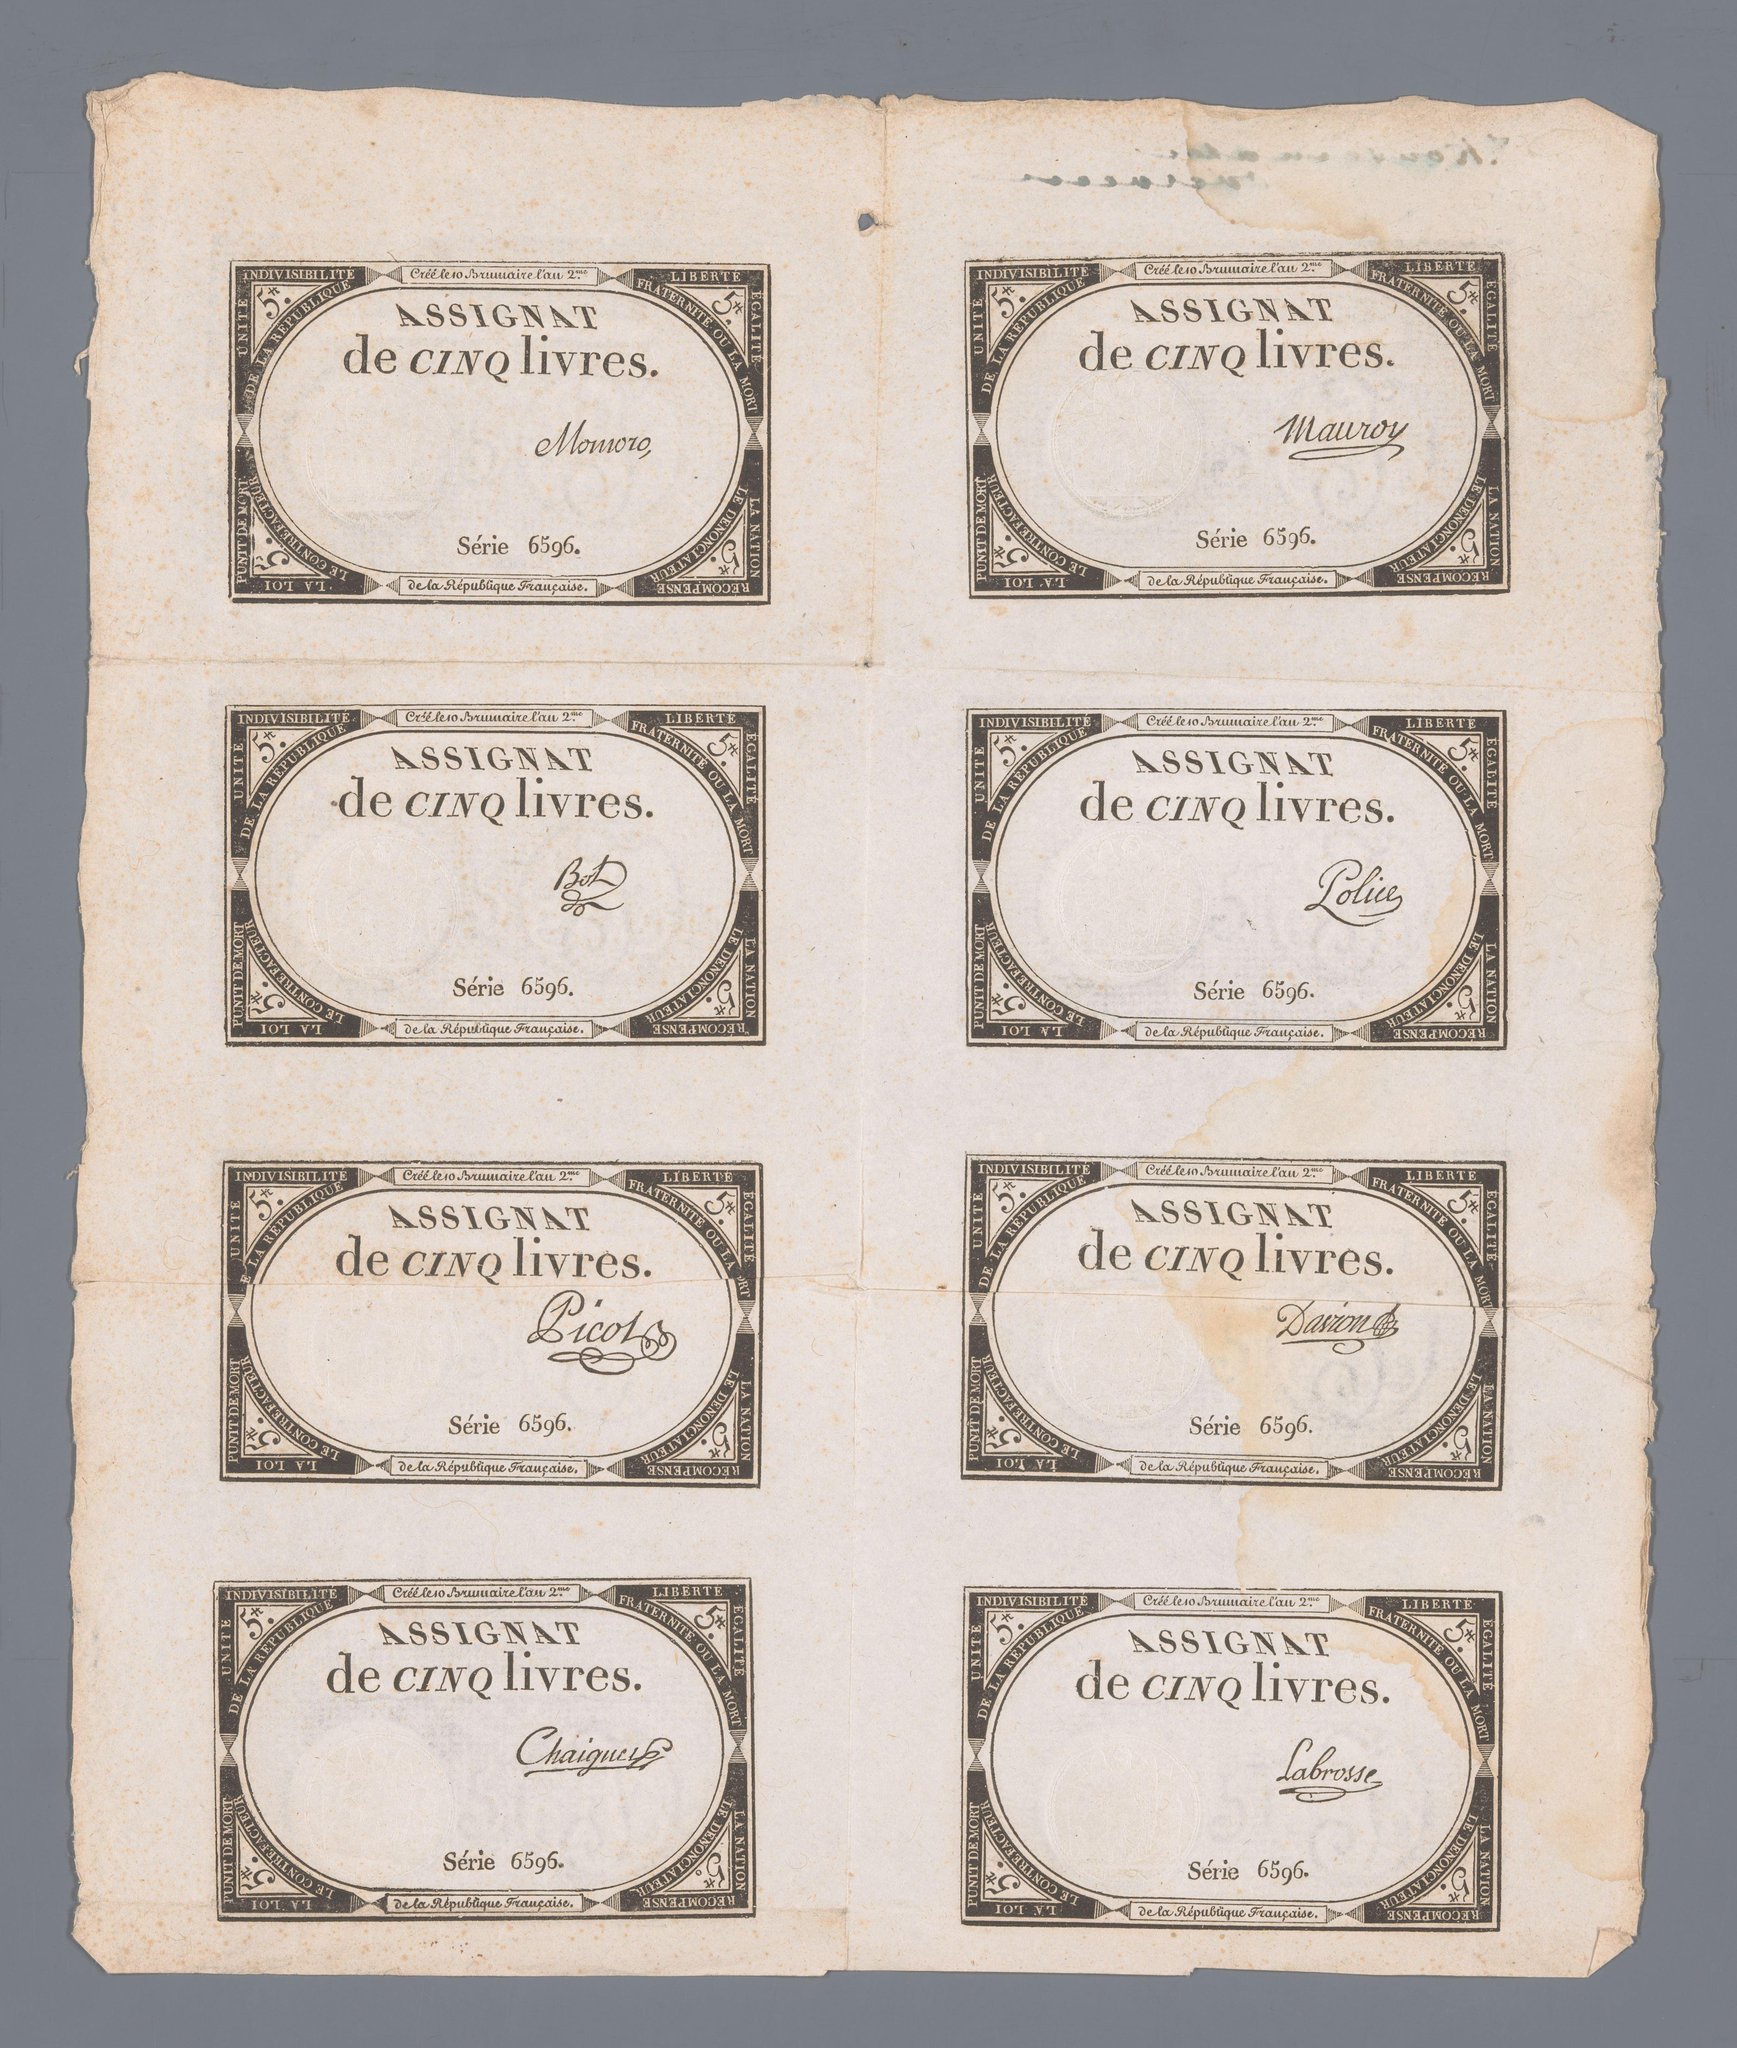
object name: assignat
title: Vel met 8 assignaten van vijf livres, serie 6596 uitgegeven 31 december 1793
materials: paper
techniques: printing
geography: france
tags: france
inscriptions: date